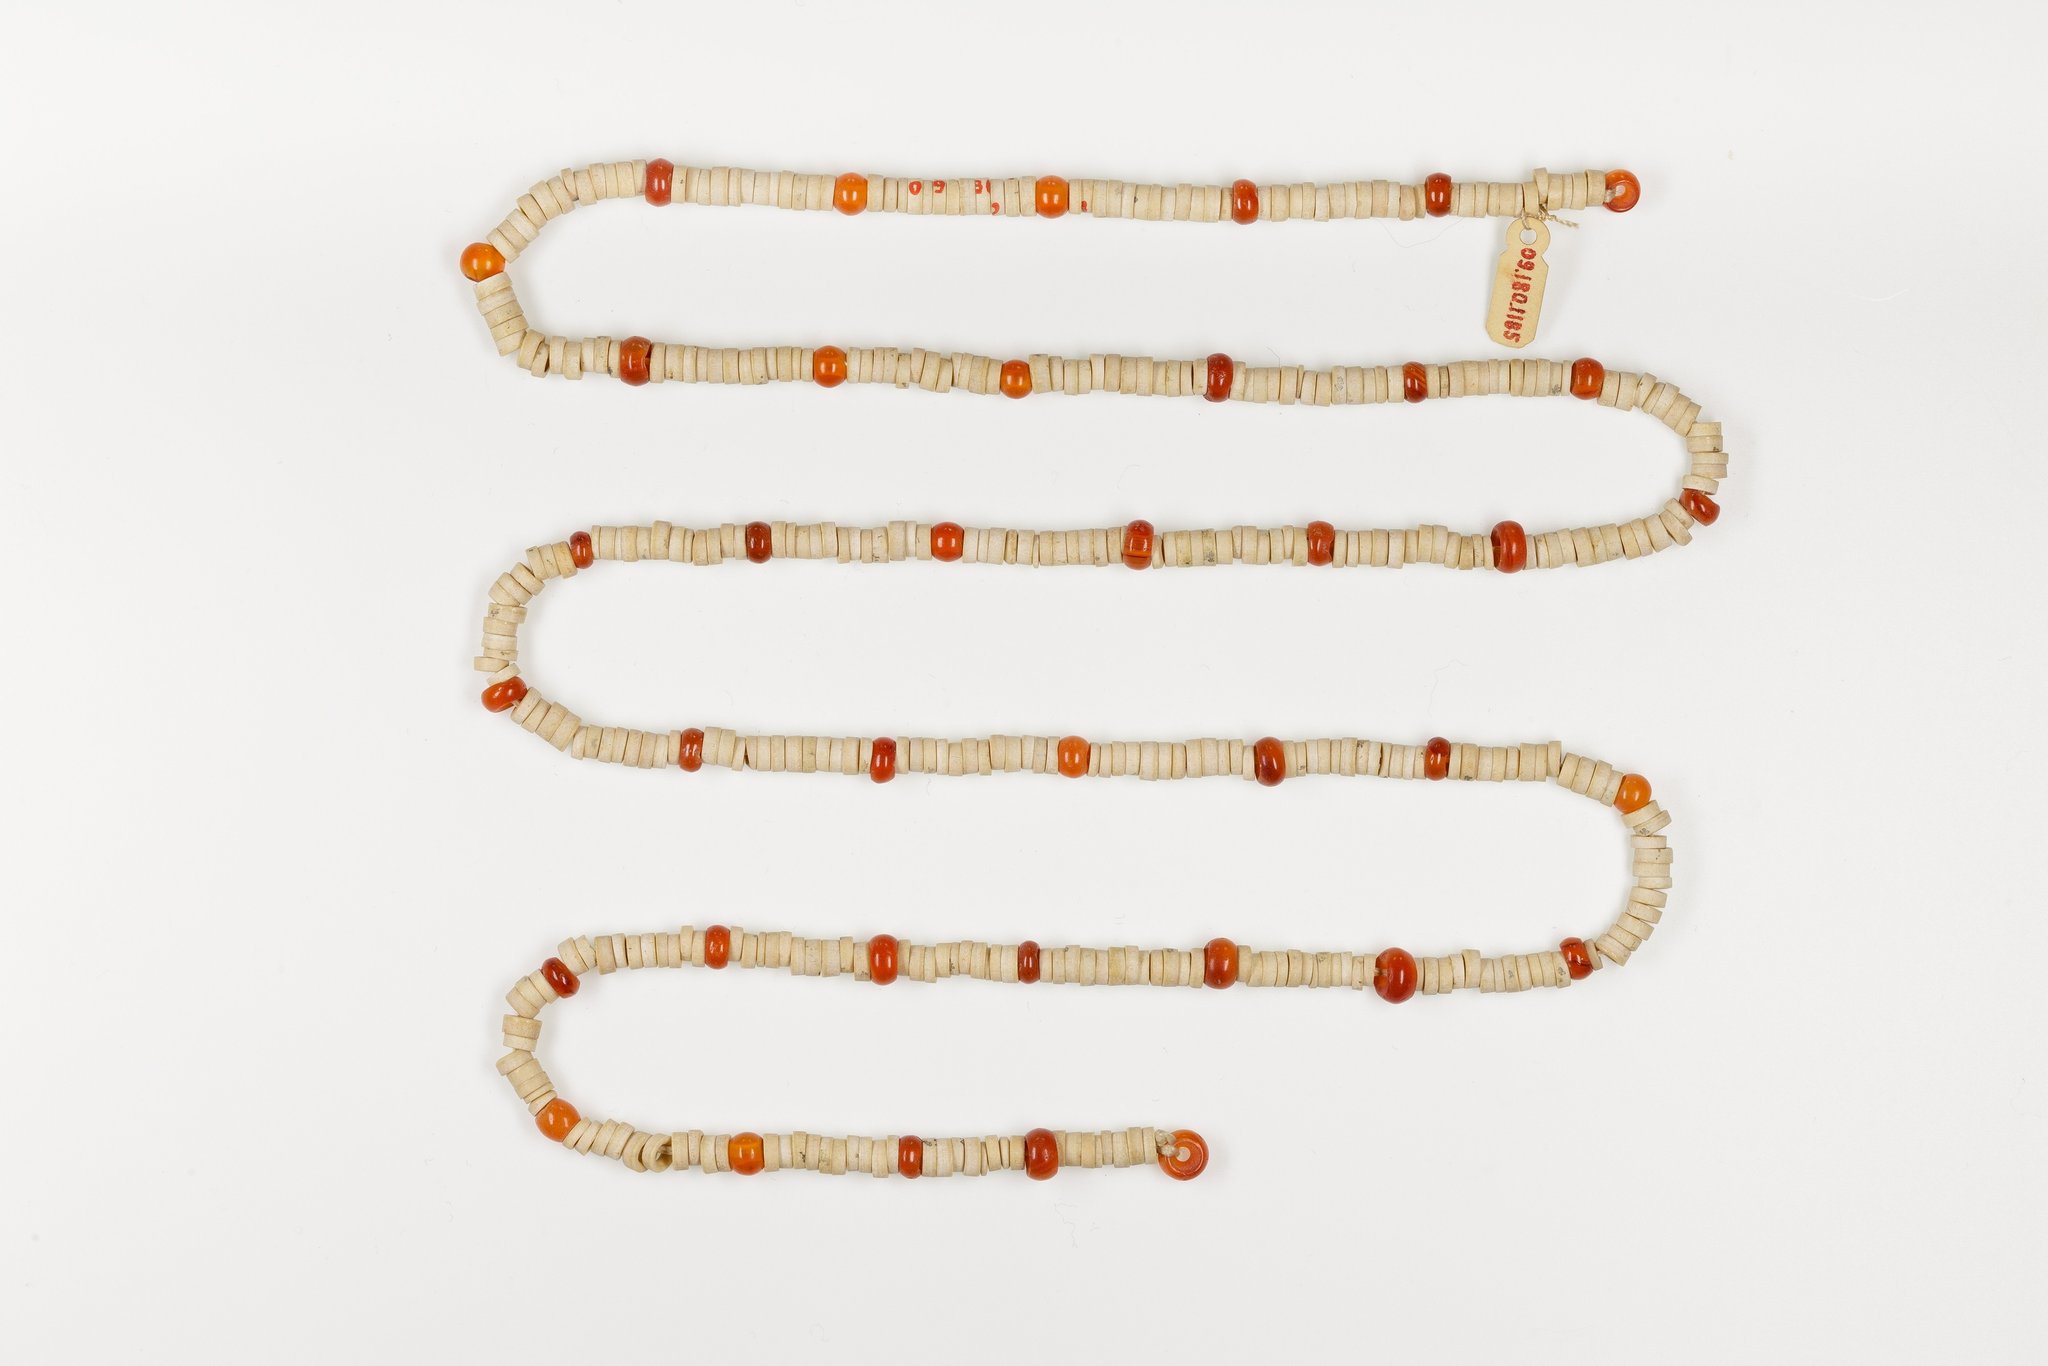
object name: 9 13 shell bead between 2 carnelian bead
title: Necklace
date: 1802-1640 BCE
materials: gemstone, shell